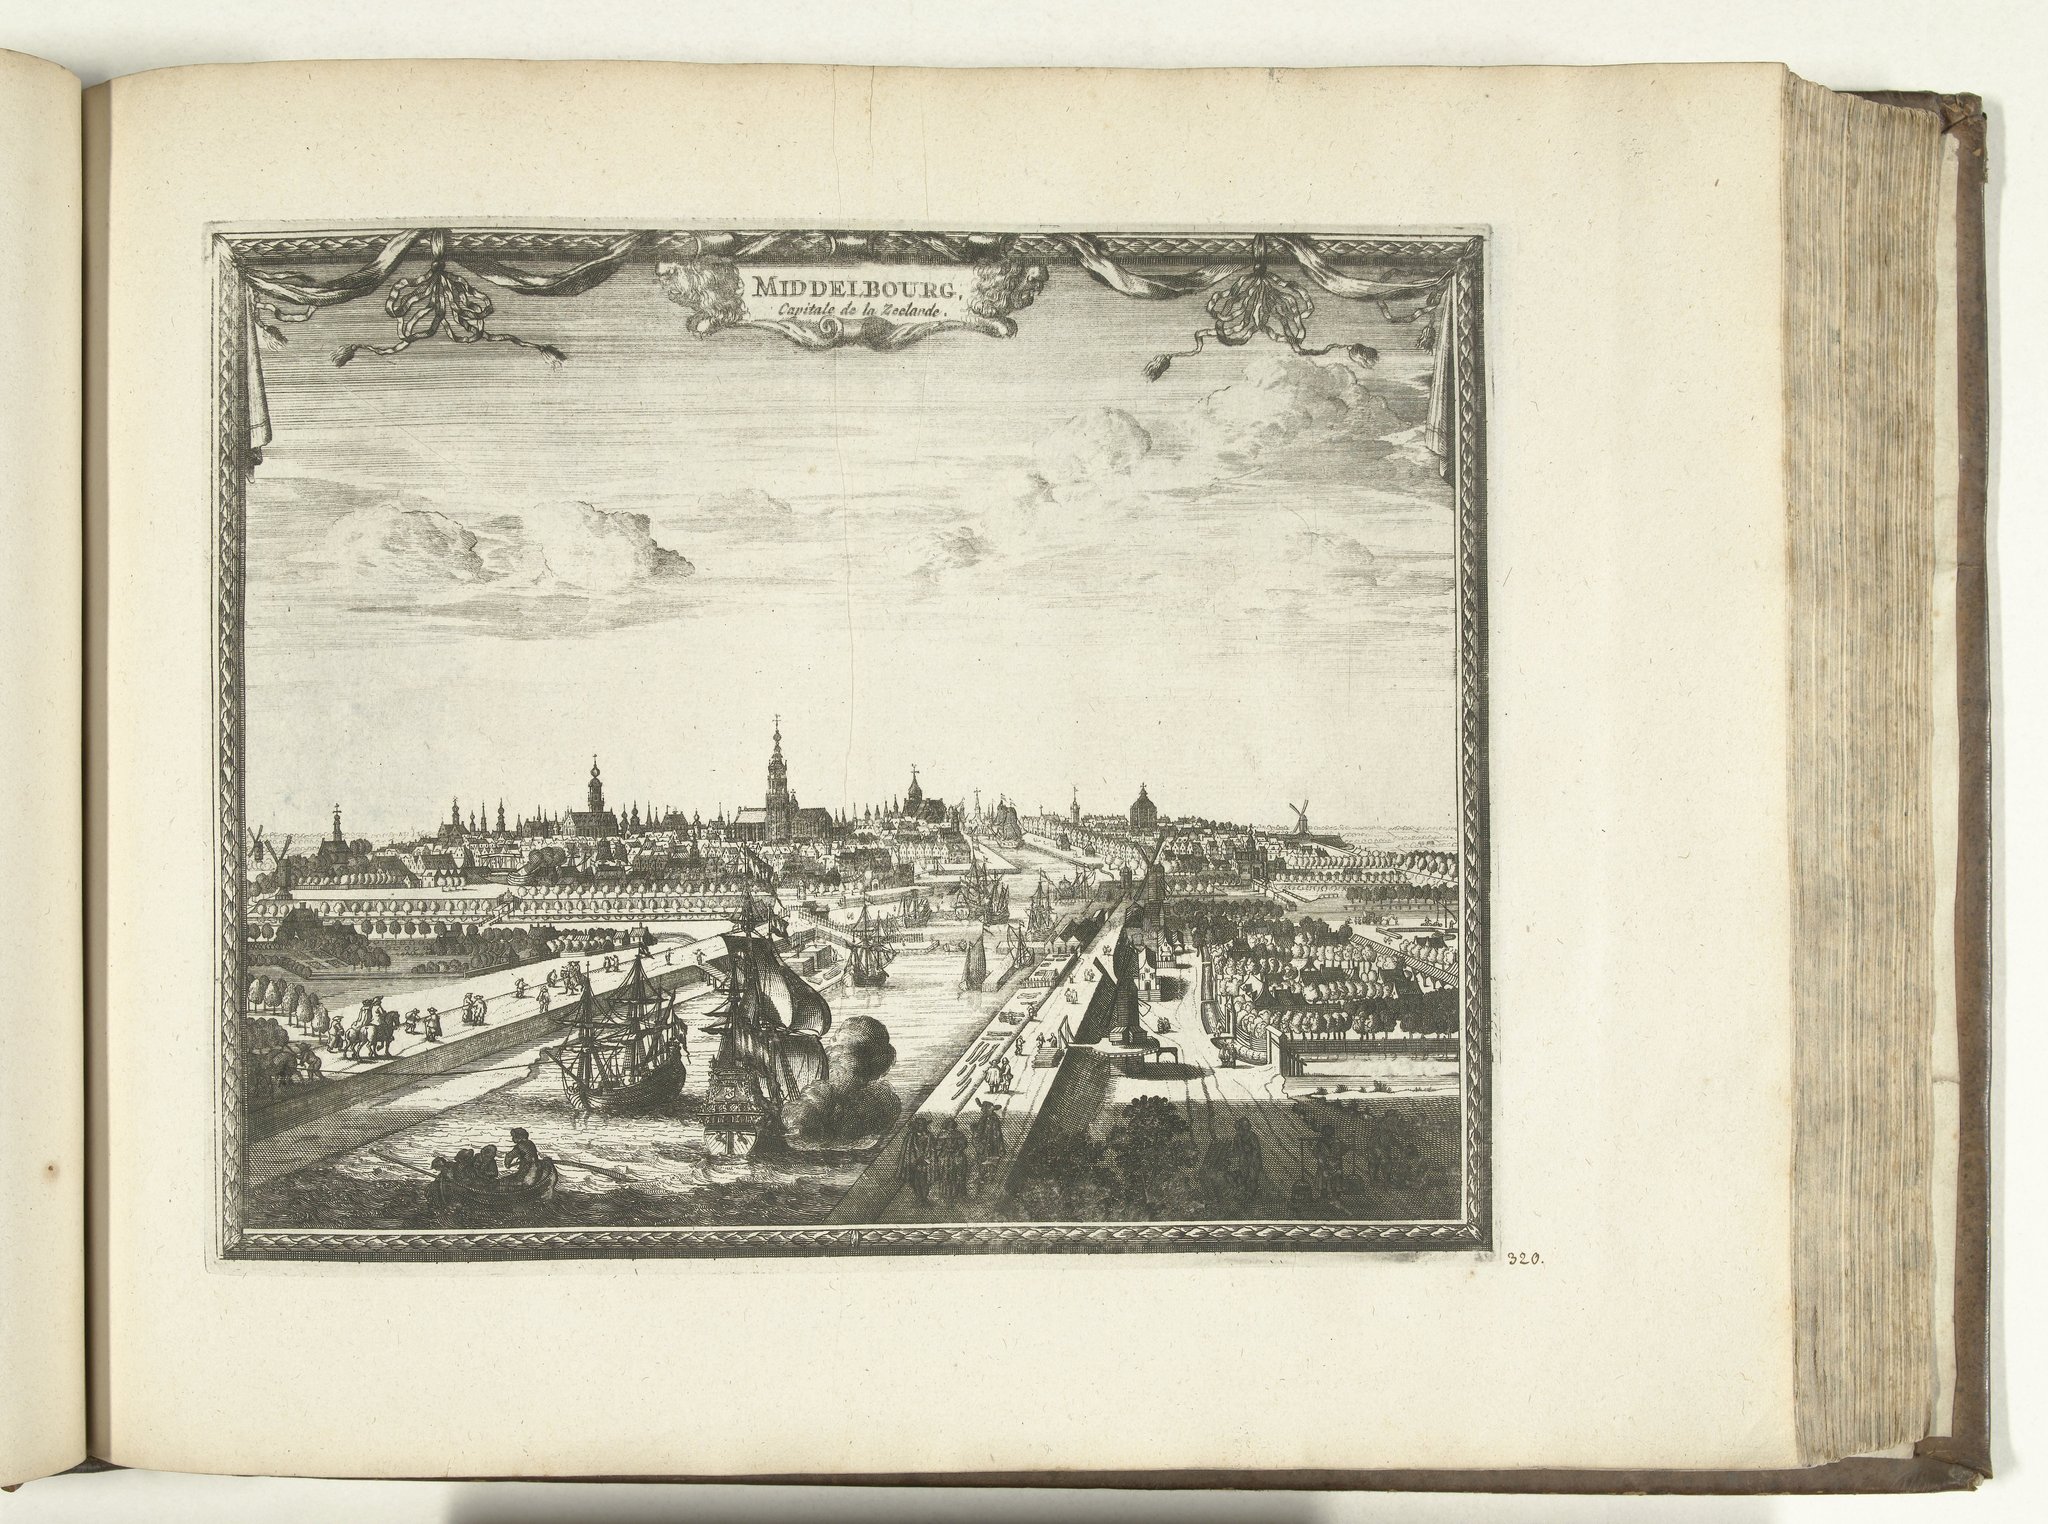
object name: print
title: Les Forces de l'Europe, Asie, Afrique et Amerique (...) Comme aussi les Cartes des Côtes de France et d'Espagne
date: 1726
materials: paper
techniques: etching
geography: northern netherlands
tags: middelburg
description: Gezicht op Middelburg, op de voorgrond het kanaal. Plaat nr. 320 in deel XIII van het prentwerk: Les Forces de l'Europe, Asie, Afrique et Amerique ... Comme aussi les Cartes des Côtes de France et d'Espagne uit 1726, dit tweede deel met 271 met de hand genummerde platen van vermaarde sterke steden en vestingen in het kader van de Spaanse Successieoorlog 1701-1713. Voor het merendeel zijn deze platen gekopieerd naar de anonieme Franse platen van vermaarde sterke steden en vestingen: in Les forces de l'Europe en in: Le theatre de la guerre, dans les Pays-Bas, beide oorspronkelijk uitgegeven door Nicolas de Fer te Parijs (1693-1697) in het kader van de Negenjarige Oorlog. Titel in het Frans.